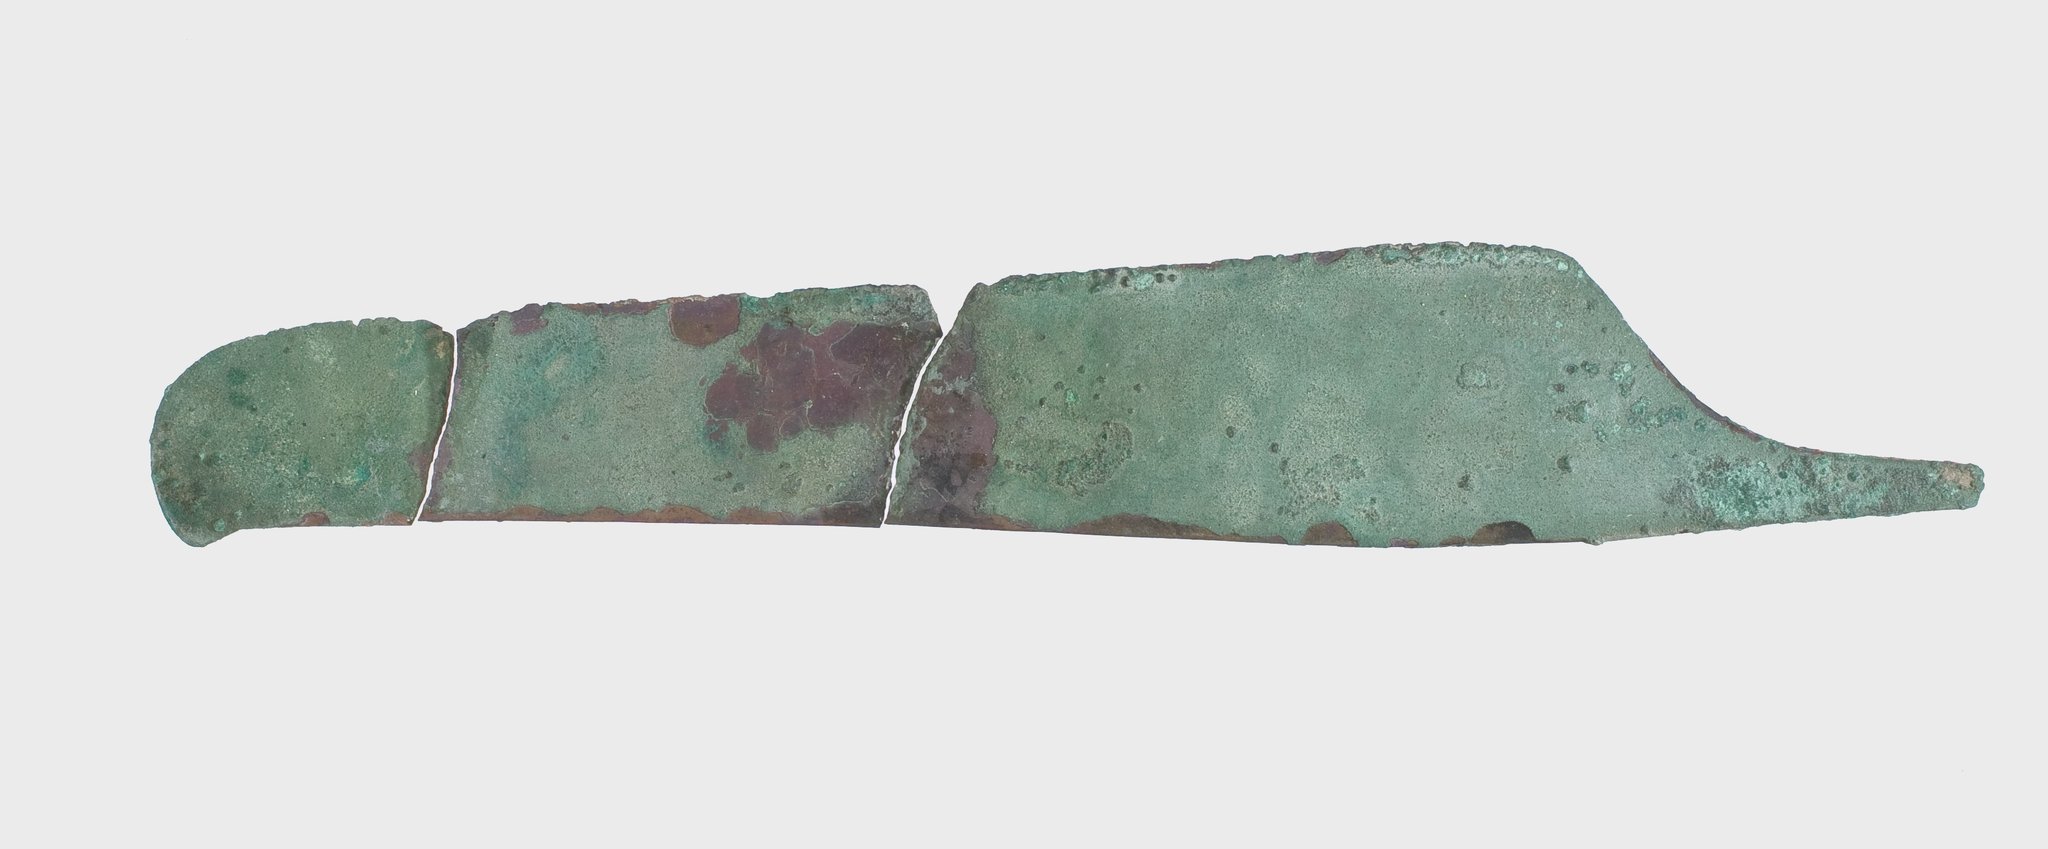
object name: knife, large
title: Knife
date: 1390-1352 BCE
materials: bronze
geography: egypt